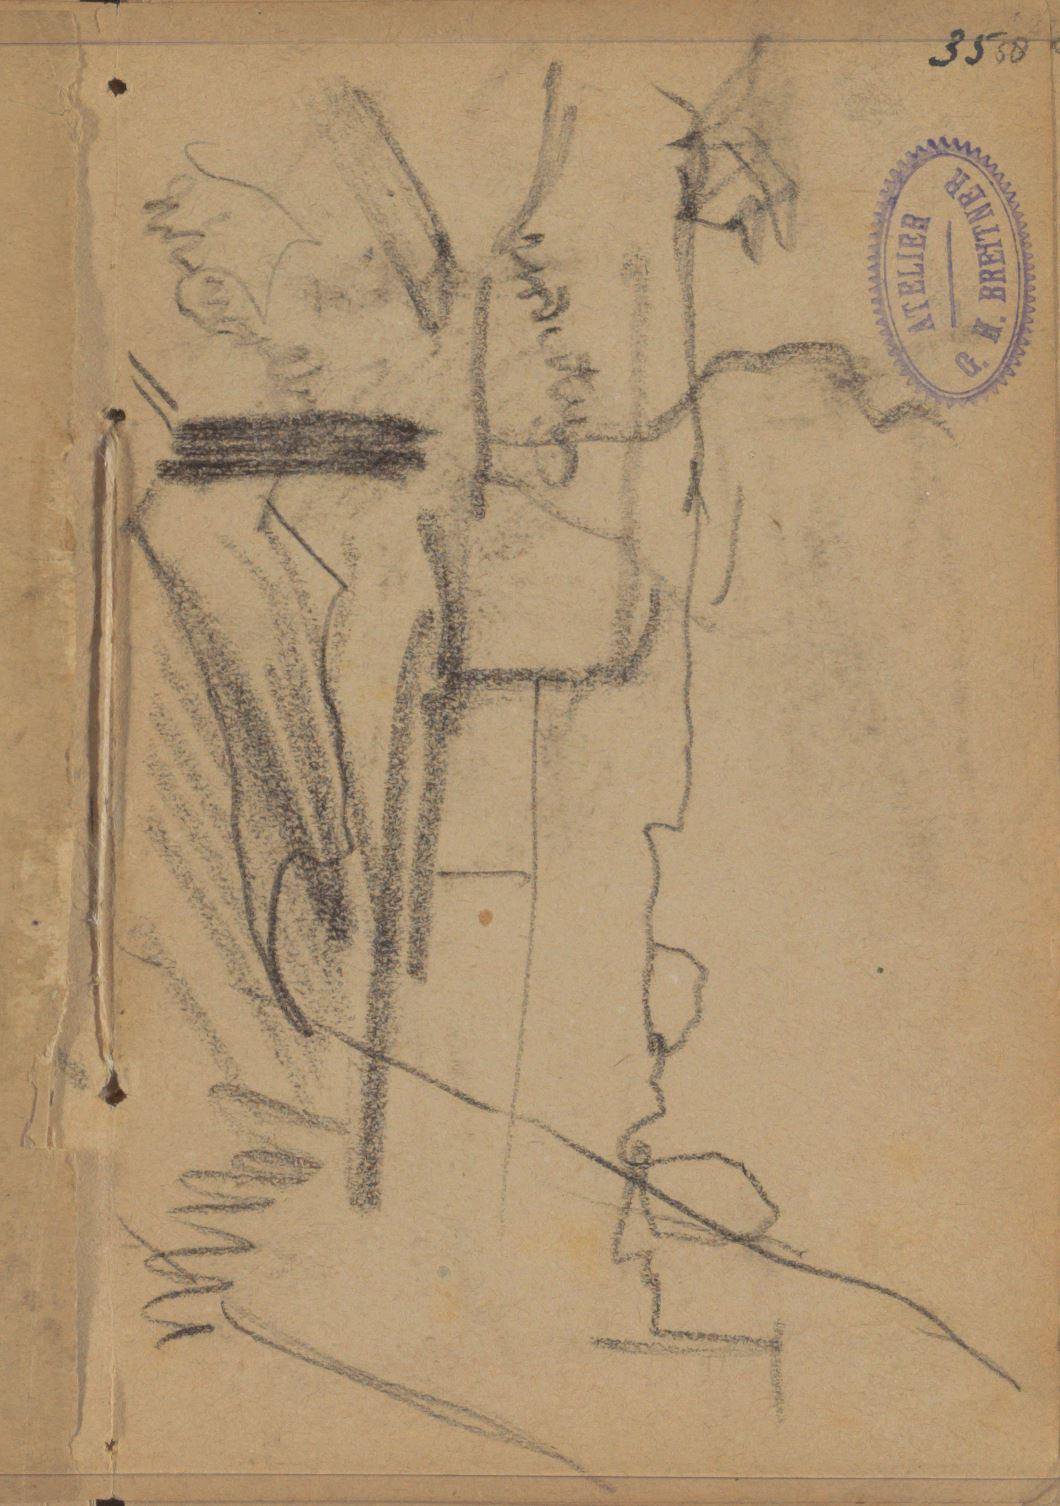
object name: sketchbook leaf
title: Studieblad, mogelijk onder andere met architectuurstudies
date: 1887-1891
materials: chalk, paper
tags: landscapes, architecture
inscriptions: workshop stamp: Lugt 291d, :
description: Pagina 58 uit een schetsboek met 83 bladen.